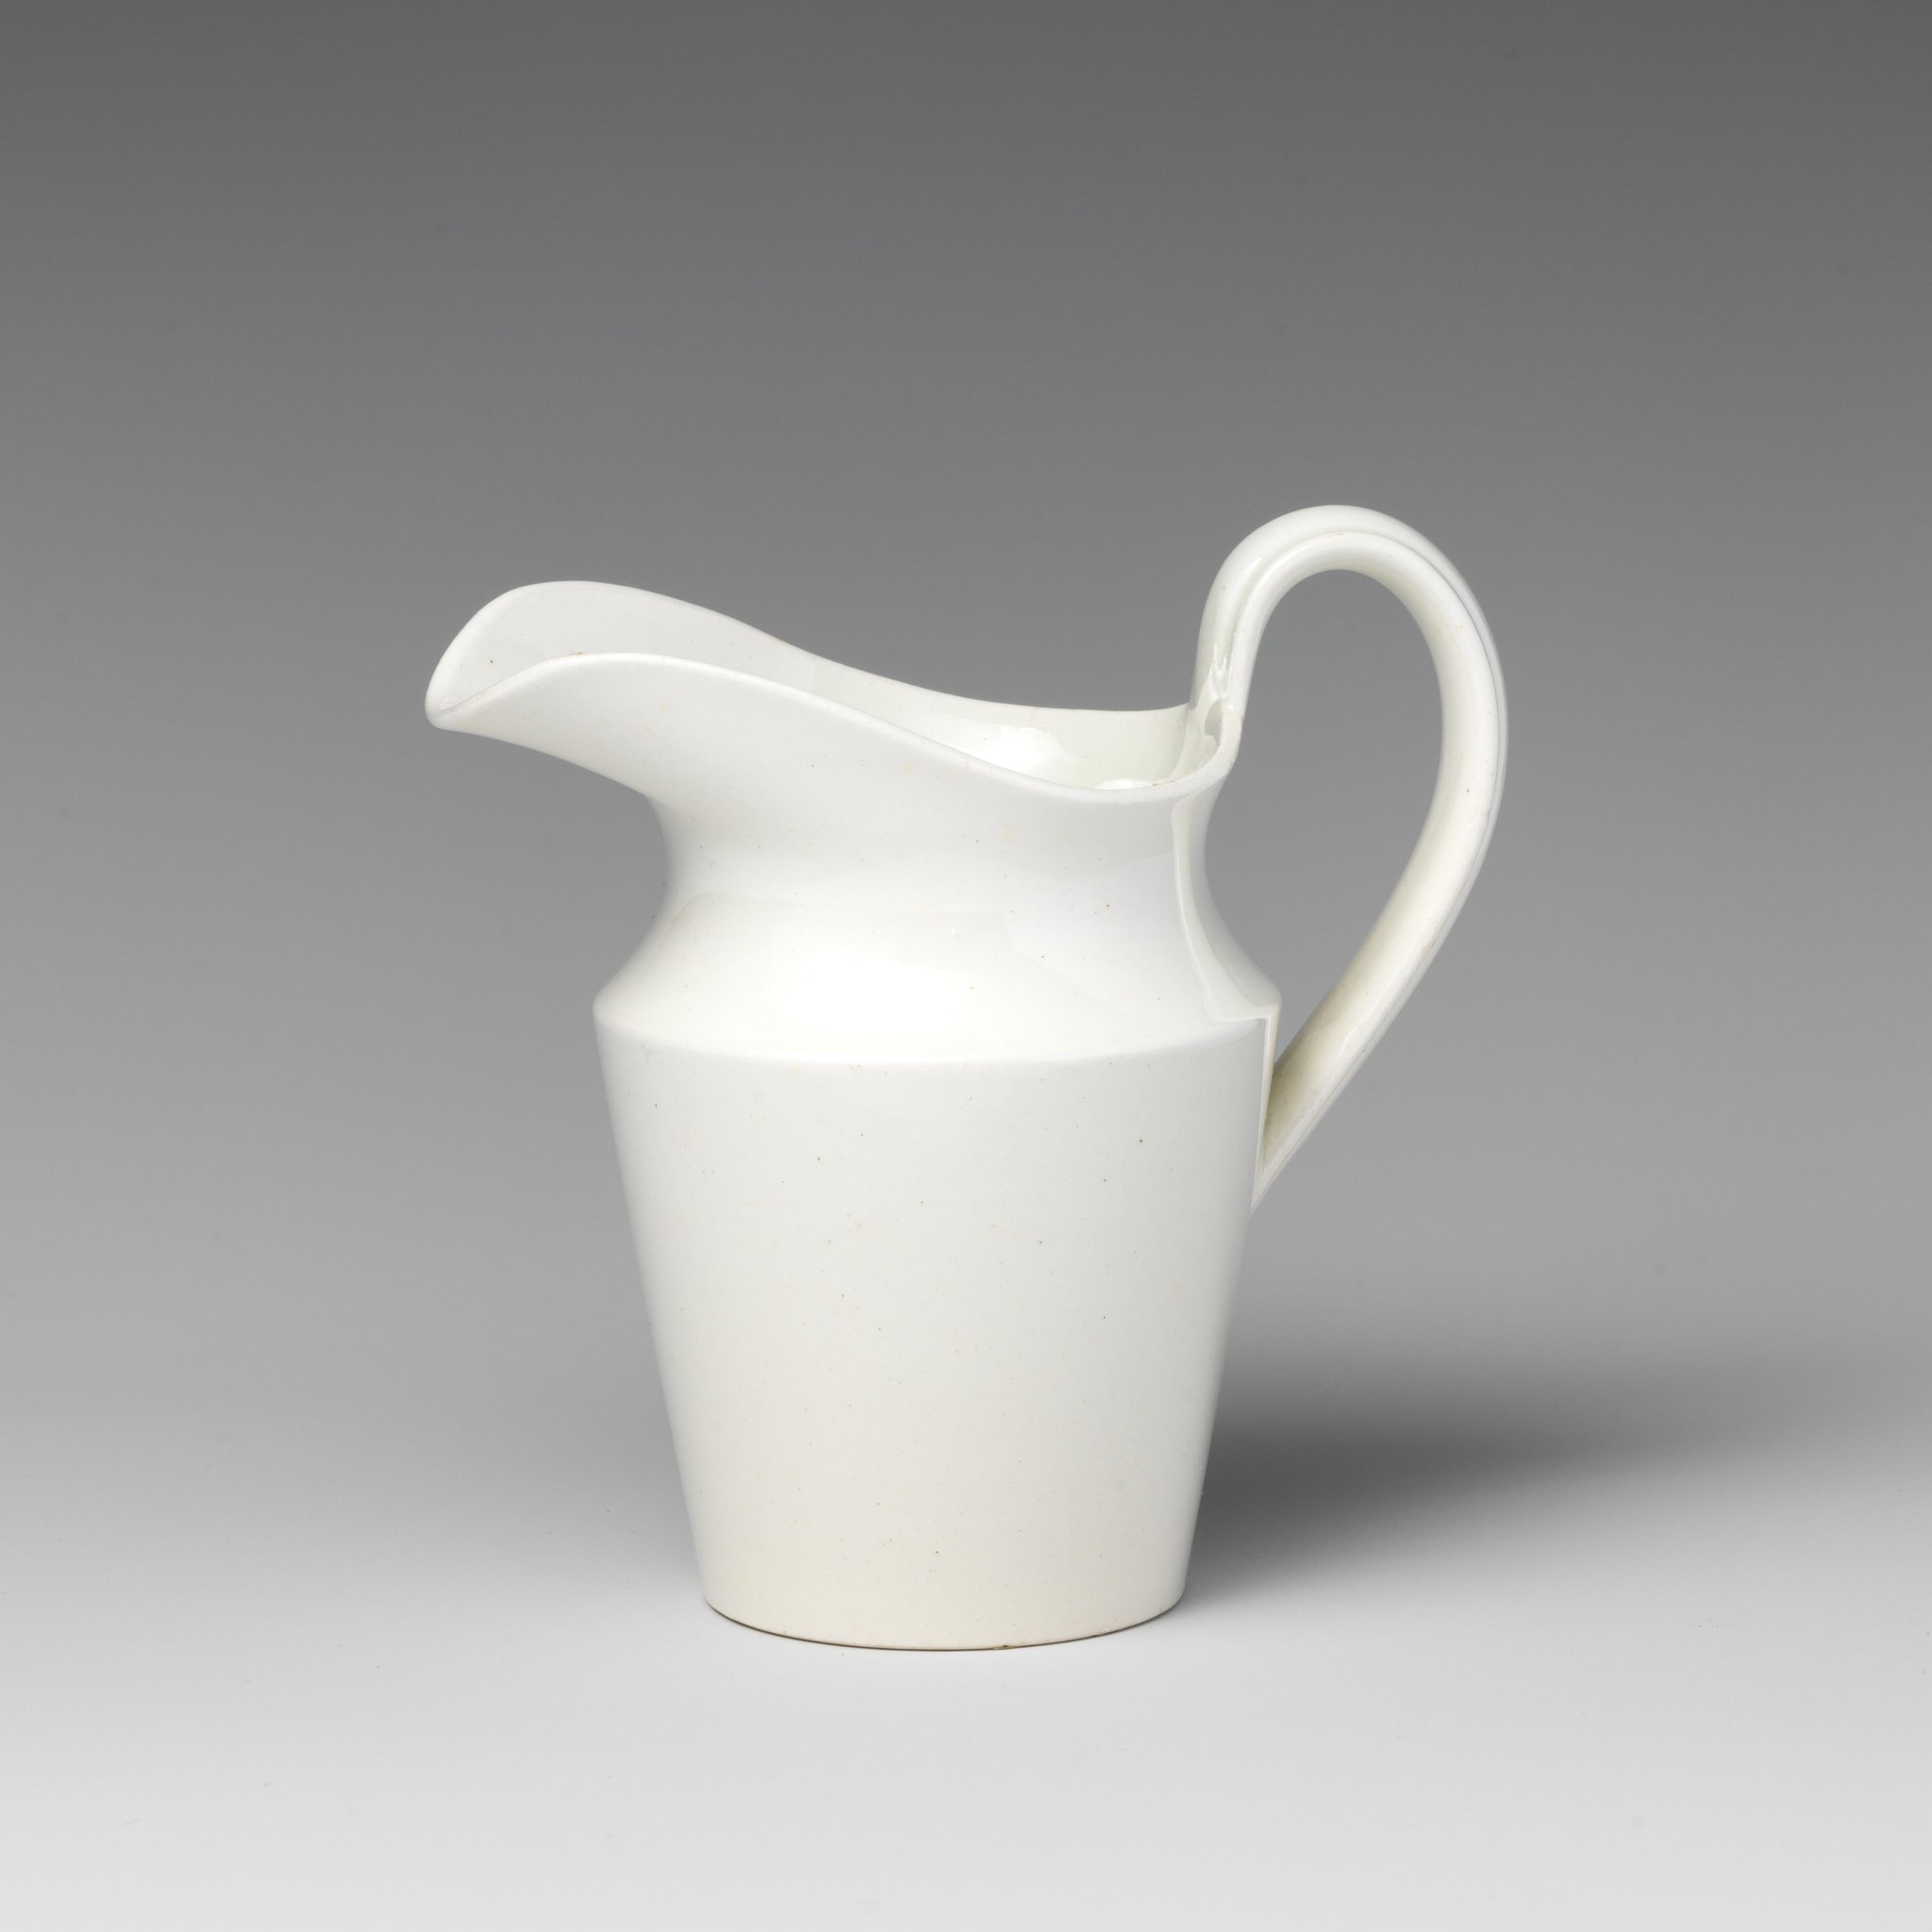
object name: miniature cream pitcher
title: Miniature cream pitcher (part of a set)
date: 1800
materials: soft paste porcelain